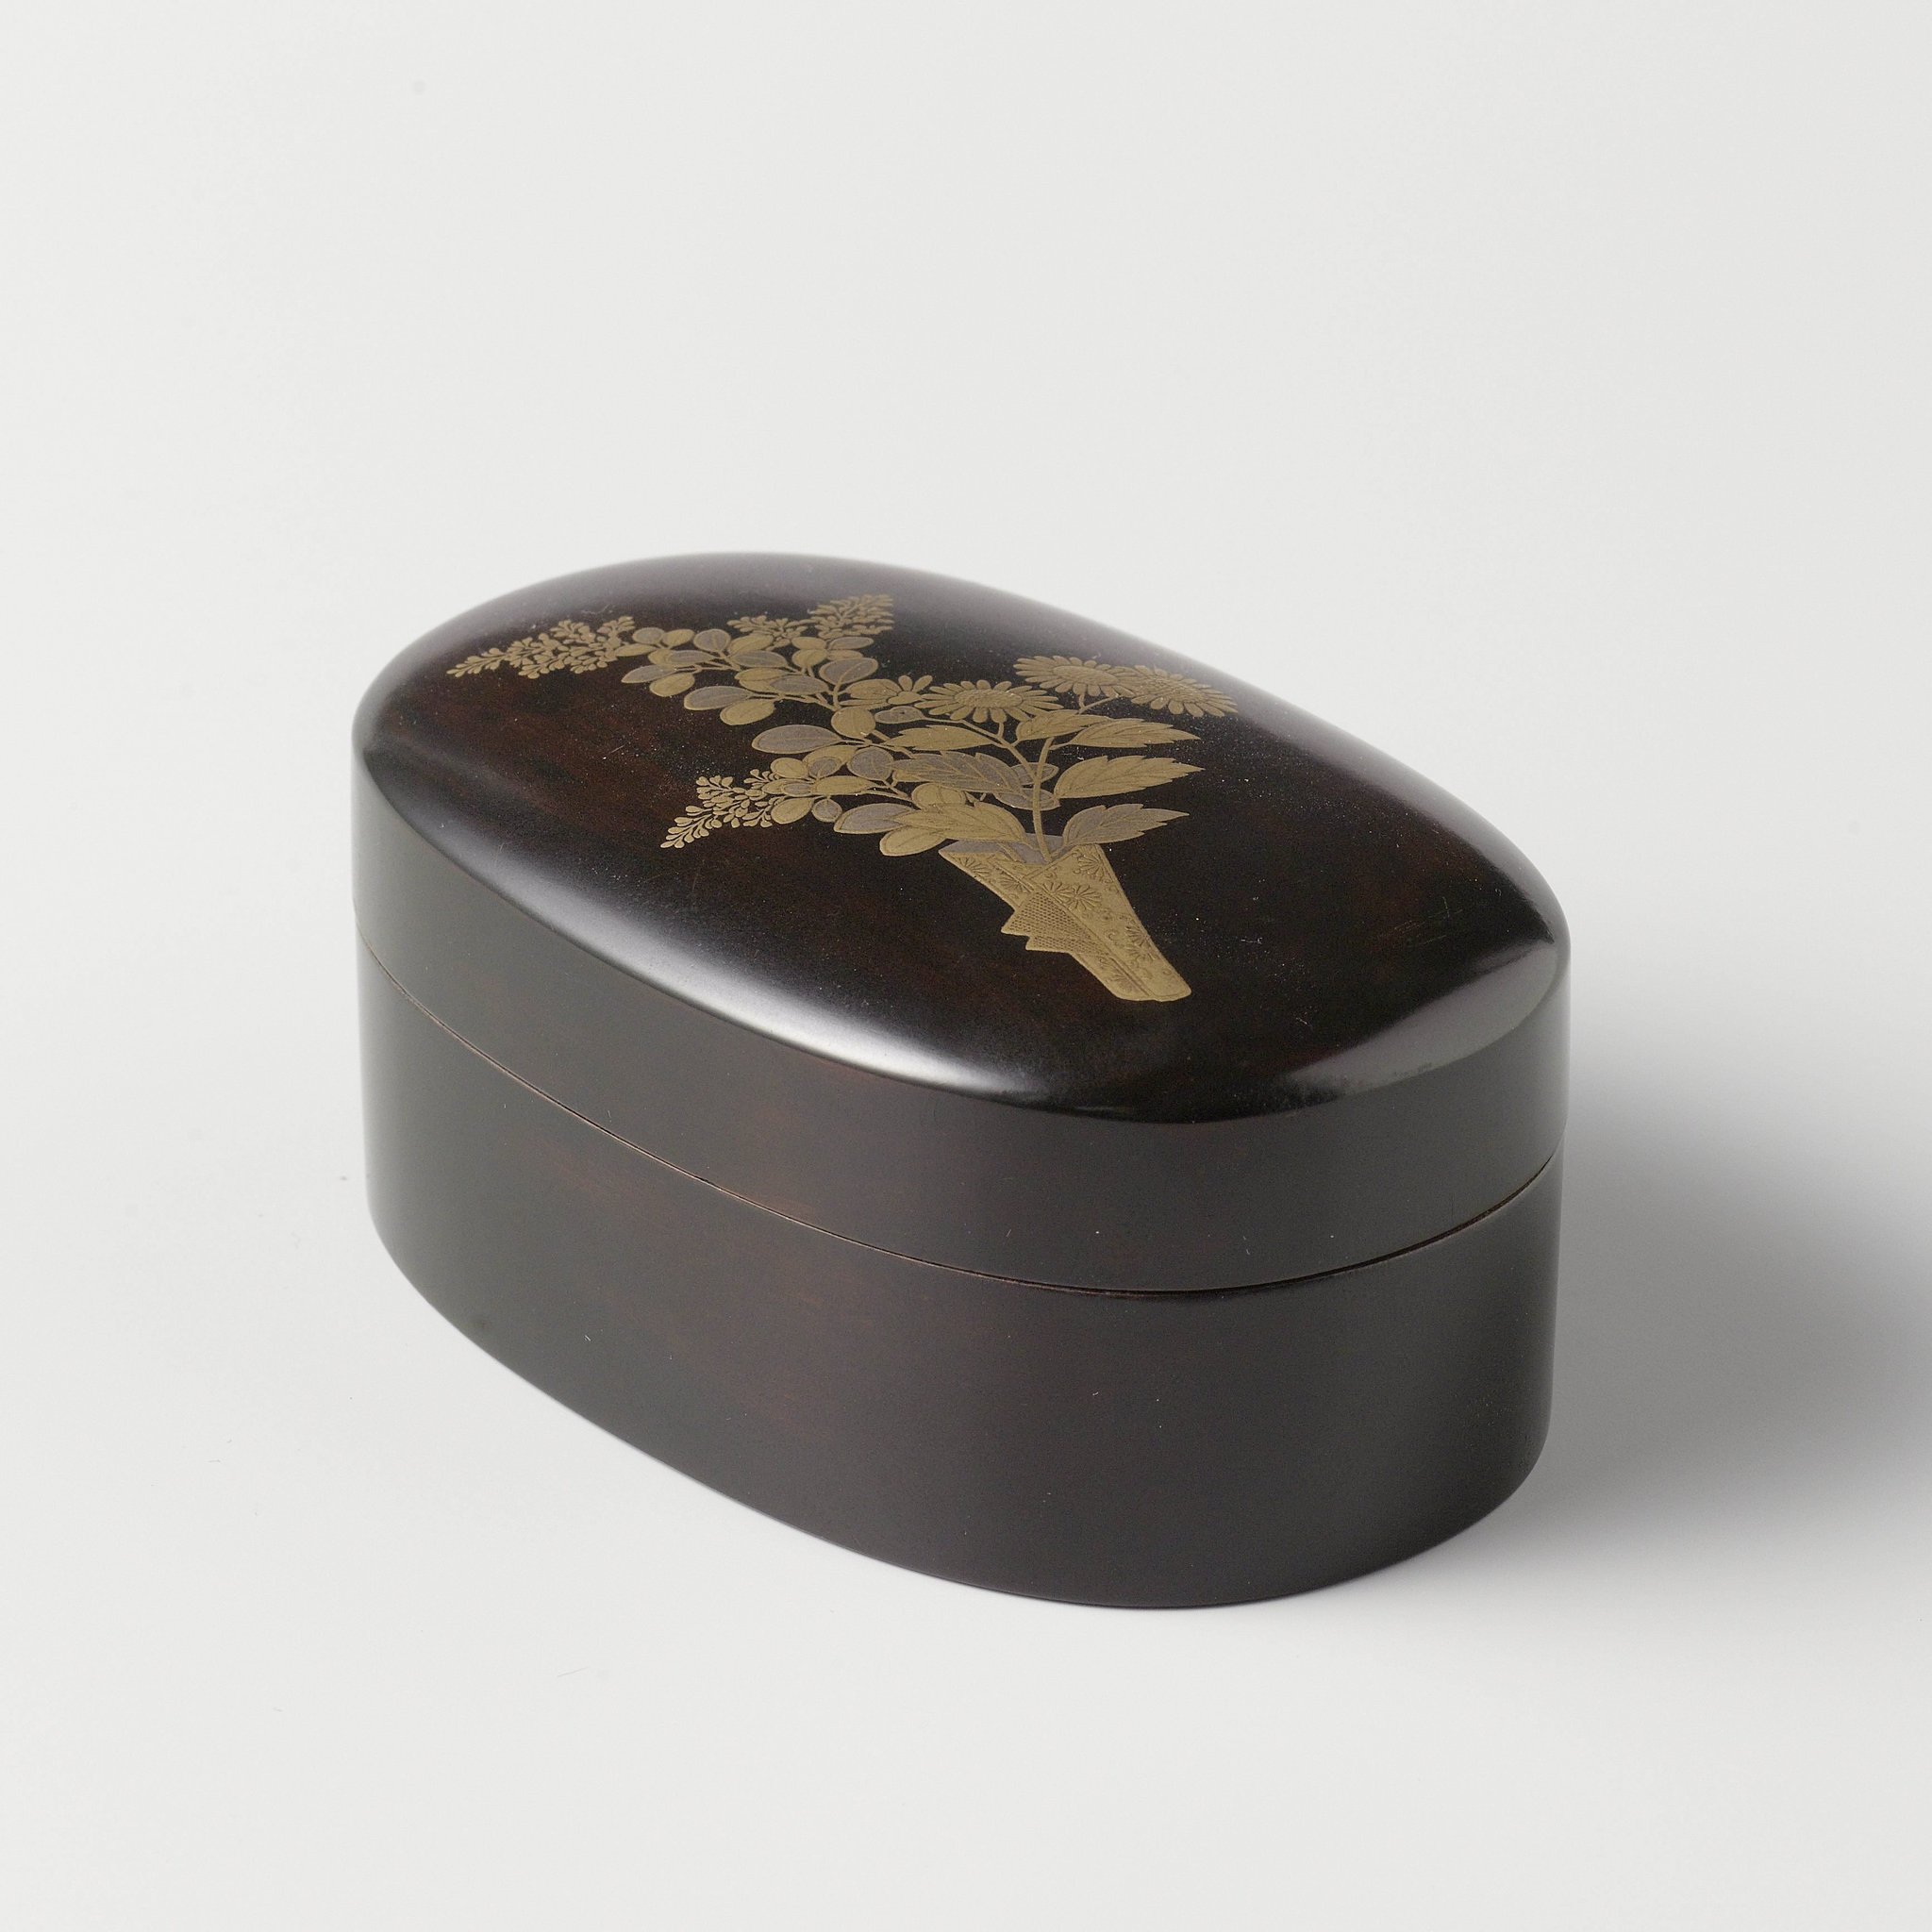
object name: box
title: Ovale doos, zwarte lak met een bloemtakken in makie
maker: Anonymous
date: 1700-1800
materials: gold, lacquer, silver, wood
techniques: lacquer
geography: japan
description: Ovaal doosje met een enigszins bolle deksel. Gedecoreerd op de deksel met een vaas met bloemen in goud-takamakie op een zwarte ondergrond.